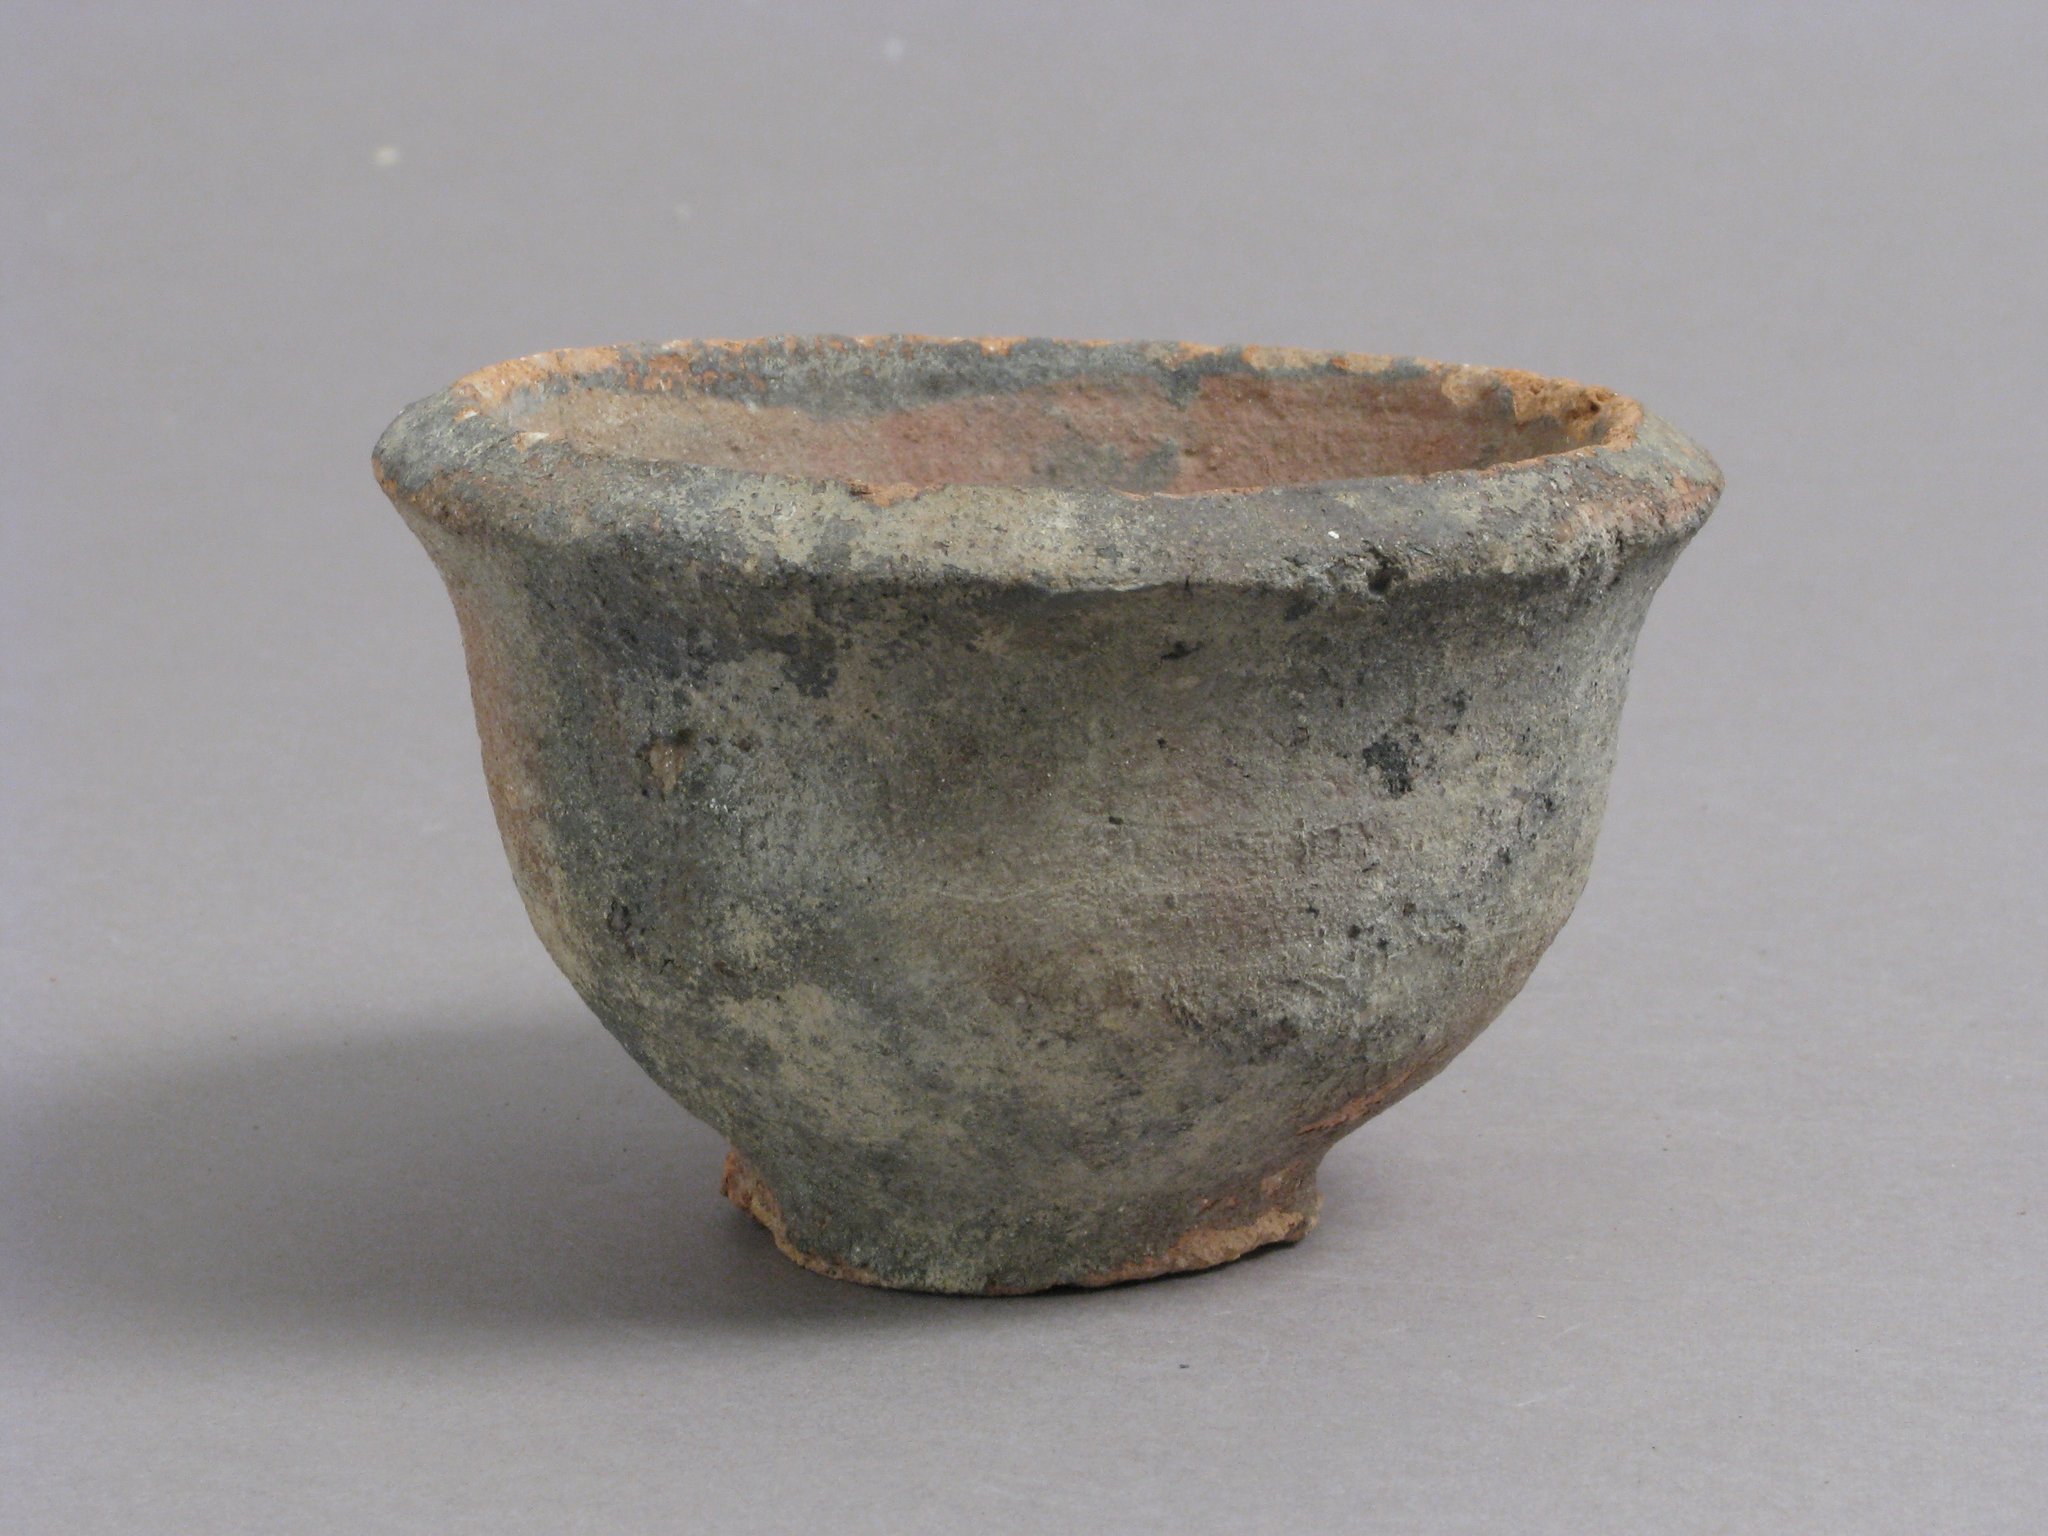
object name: bowl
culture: coptic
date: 301-700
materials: earthenware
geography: egypt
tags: bowls